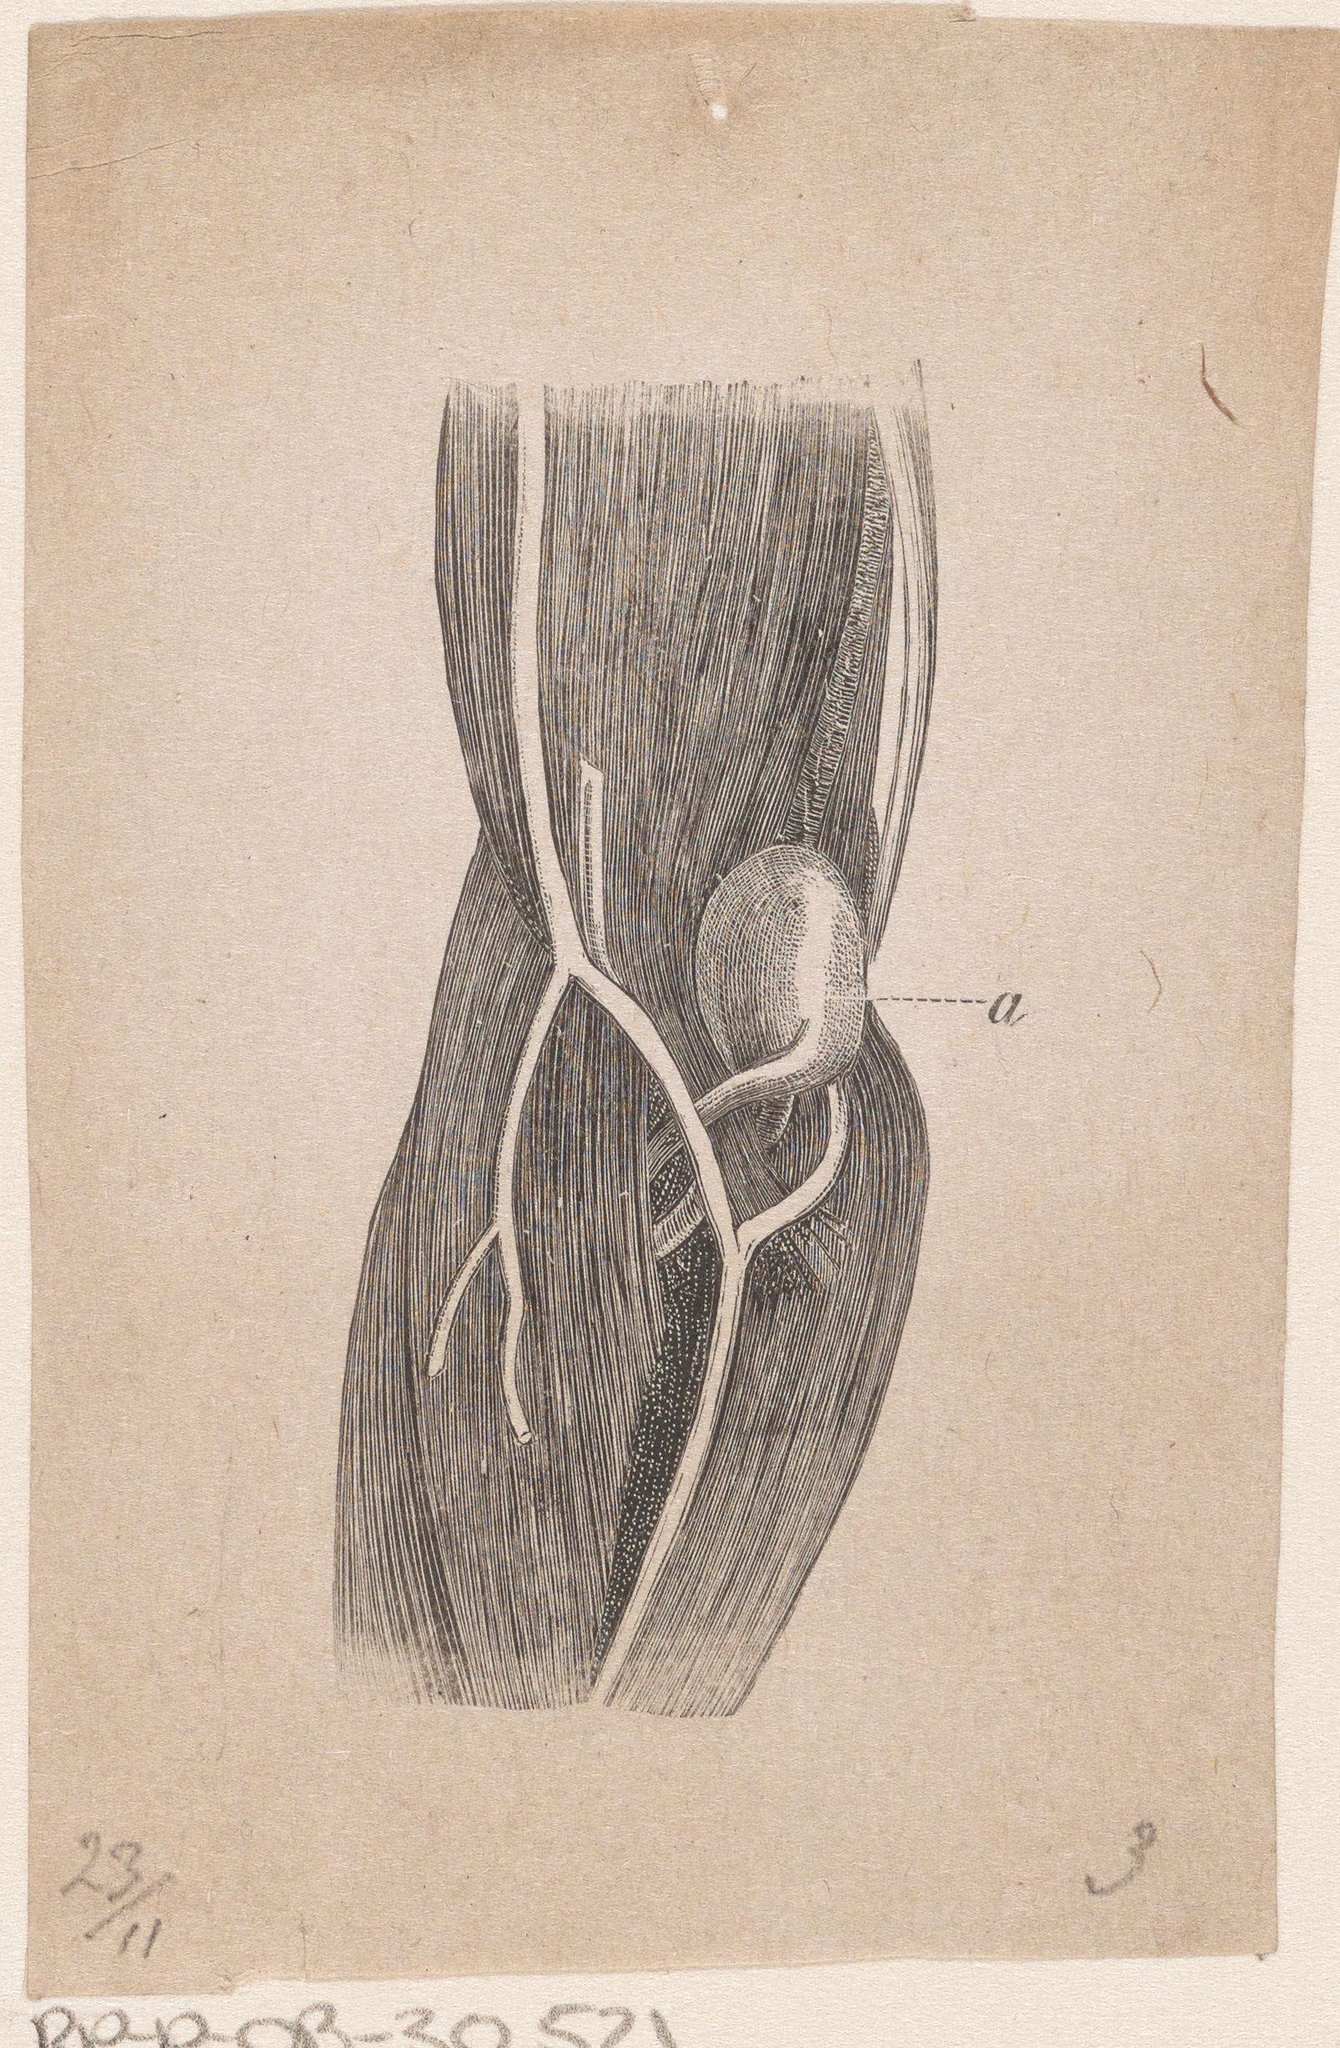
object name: print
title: Onderdeel van het menselijk lichaam met een afwijking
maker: isaac weissenbruch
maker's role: print maker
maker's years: 1826-1912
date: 1836-1912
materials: paper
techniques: engraving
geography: netherlands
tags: anatomy (non-medical), diseases